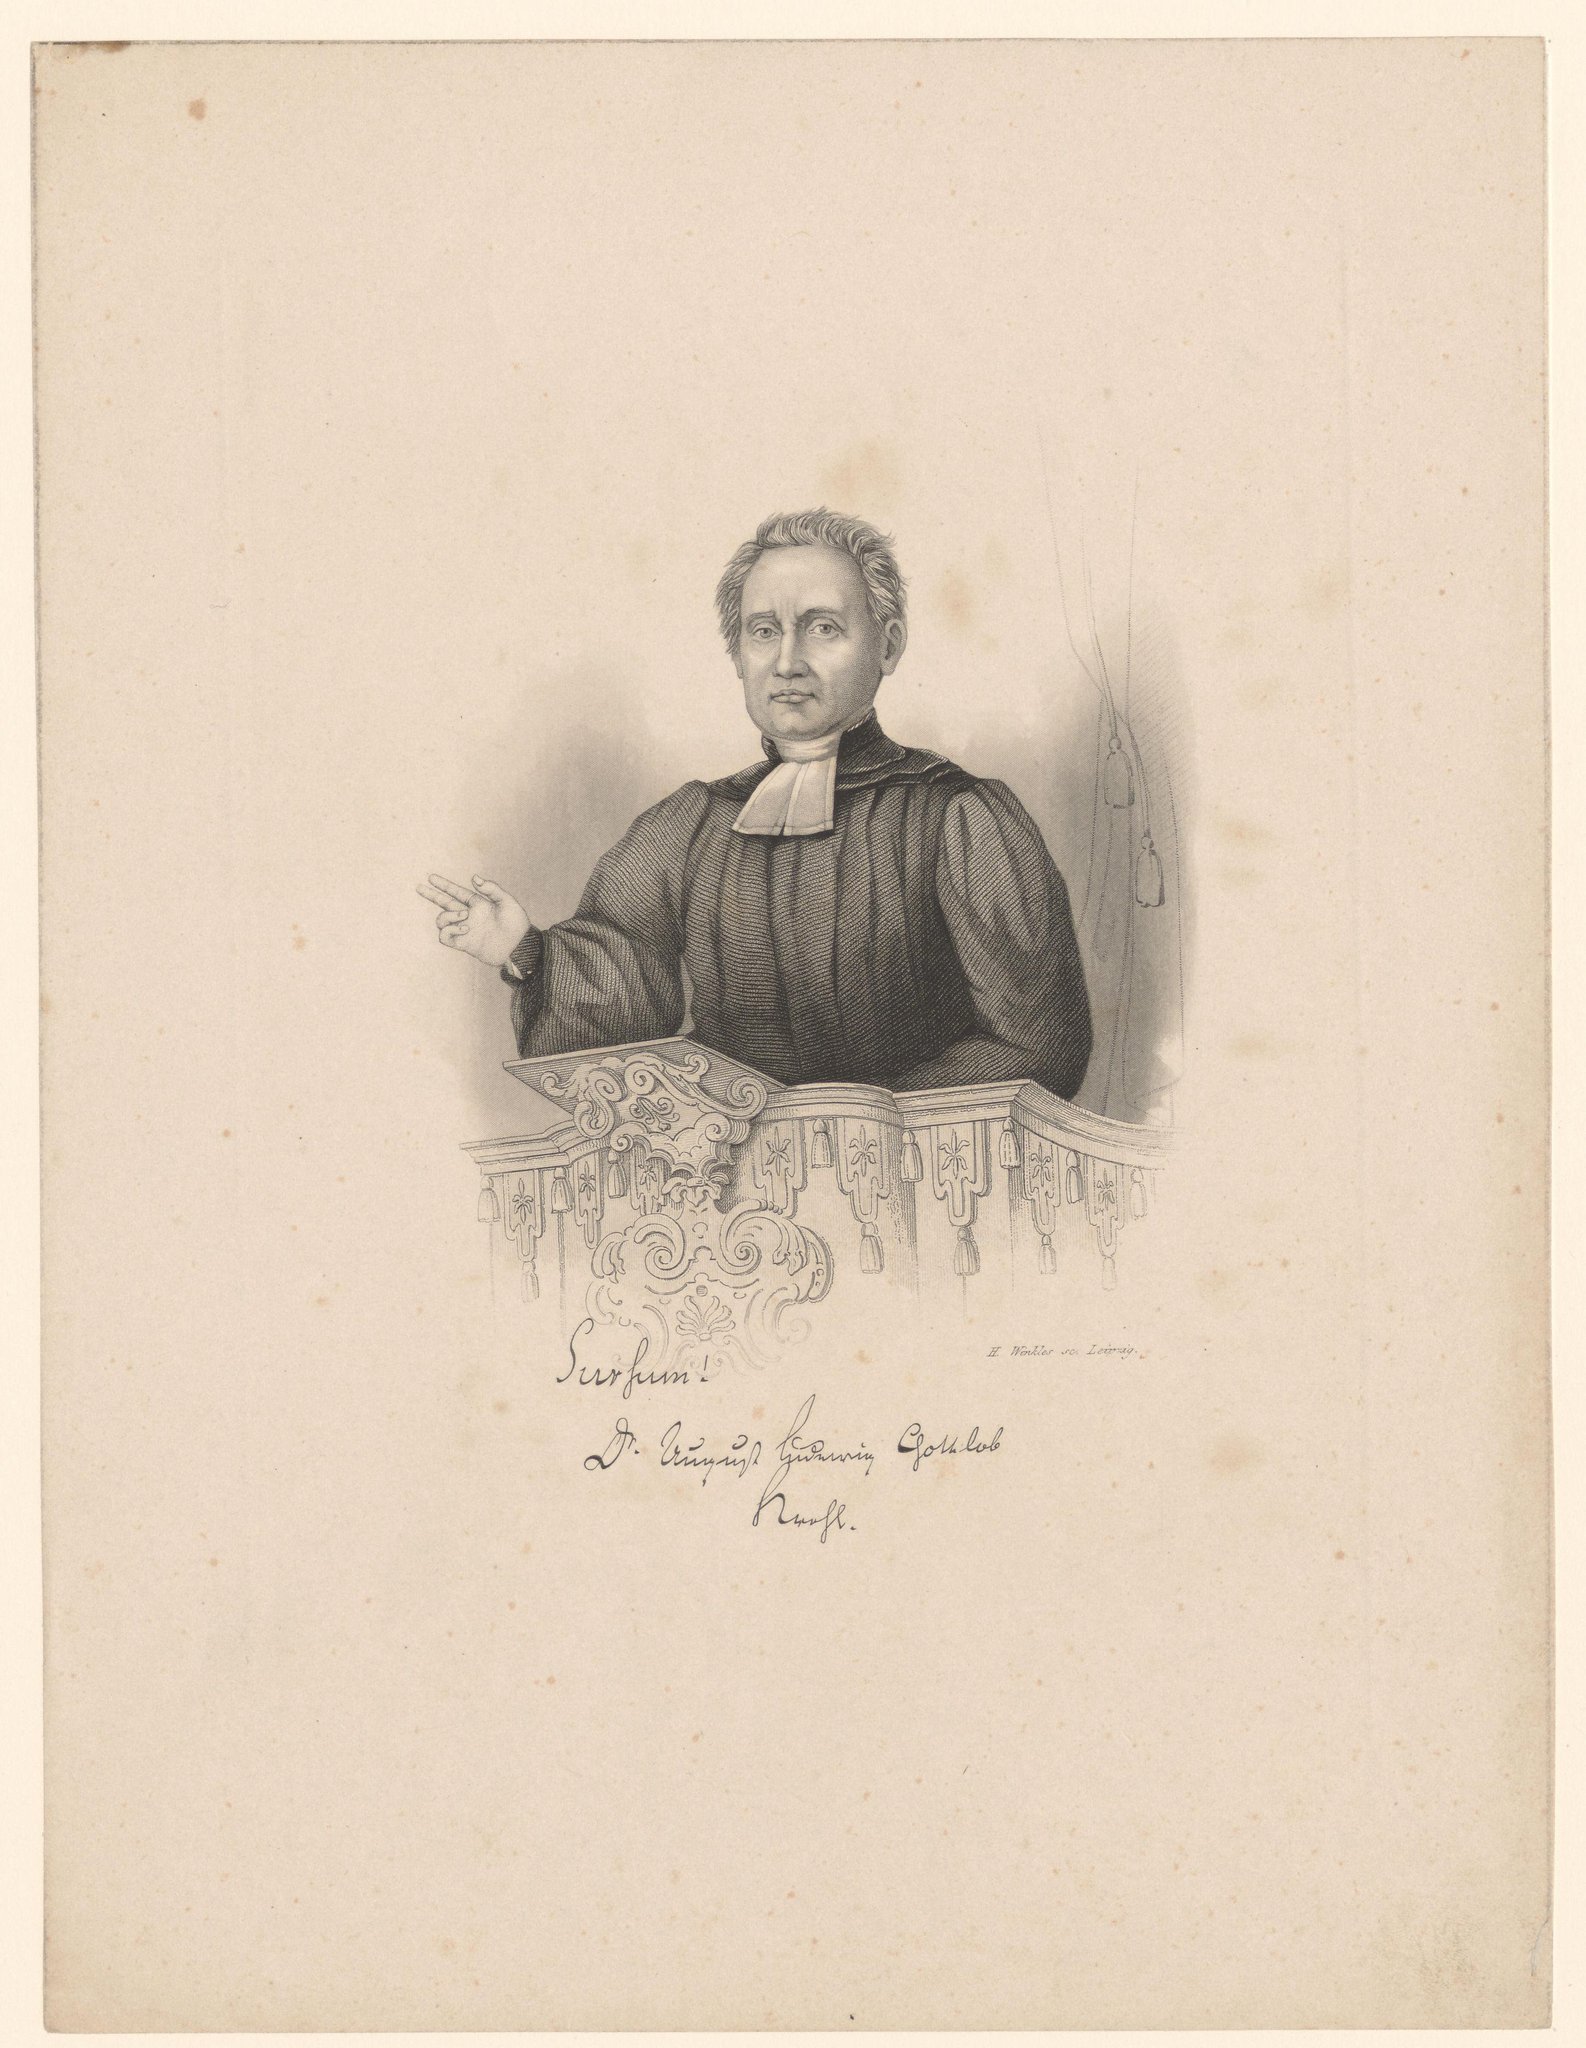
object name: print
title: Portret van August Ludwig Gottlob Krehl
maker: henry winkles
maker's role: painter, print maker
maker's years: 1801-1860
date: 1824-1860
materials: paper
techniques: etching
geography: leipzig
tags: theologian, historical persons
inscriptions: collector's mark: Lugt 2228